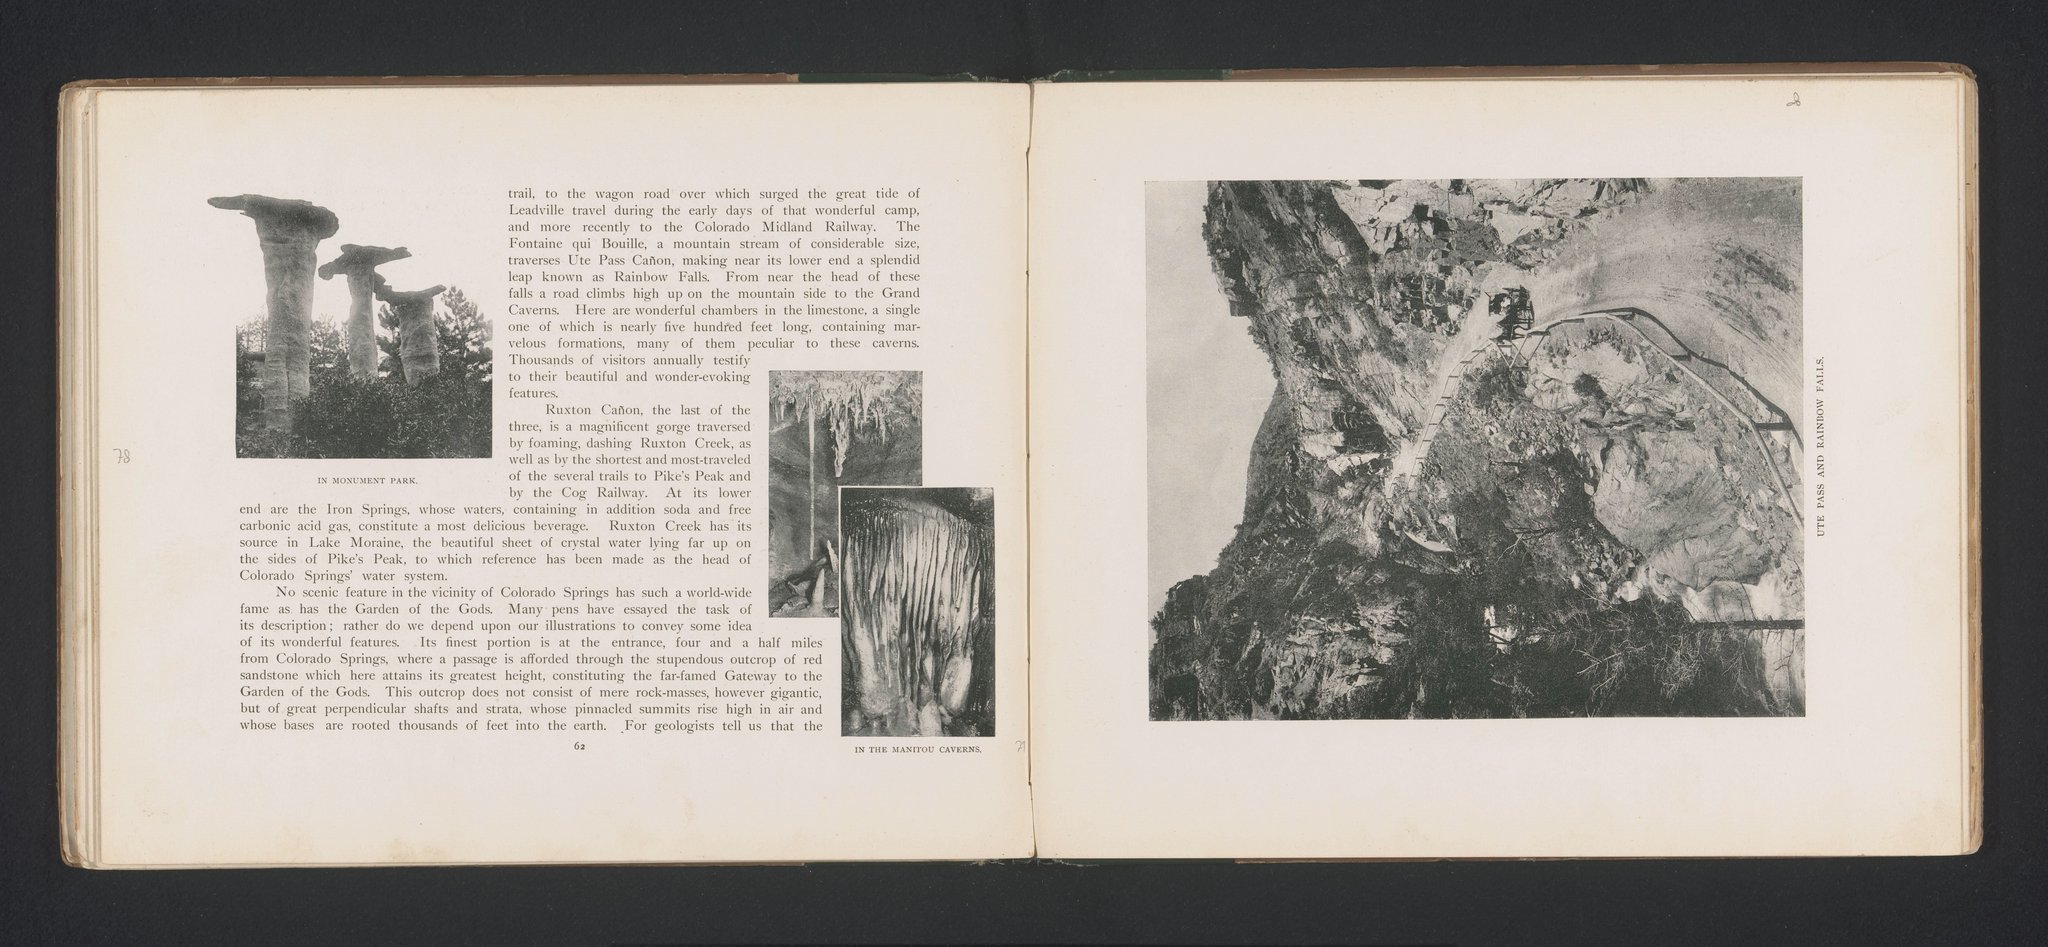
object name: page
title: In Monument Park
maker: Anonymous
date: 1888-1893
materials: paper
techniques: autotype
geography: new york city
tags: landscapes, ravine, chasm, abyss, canyon